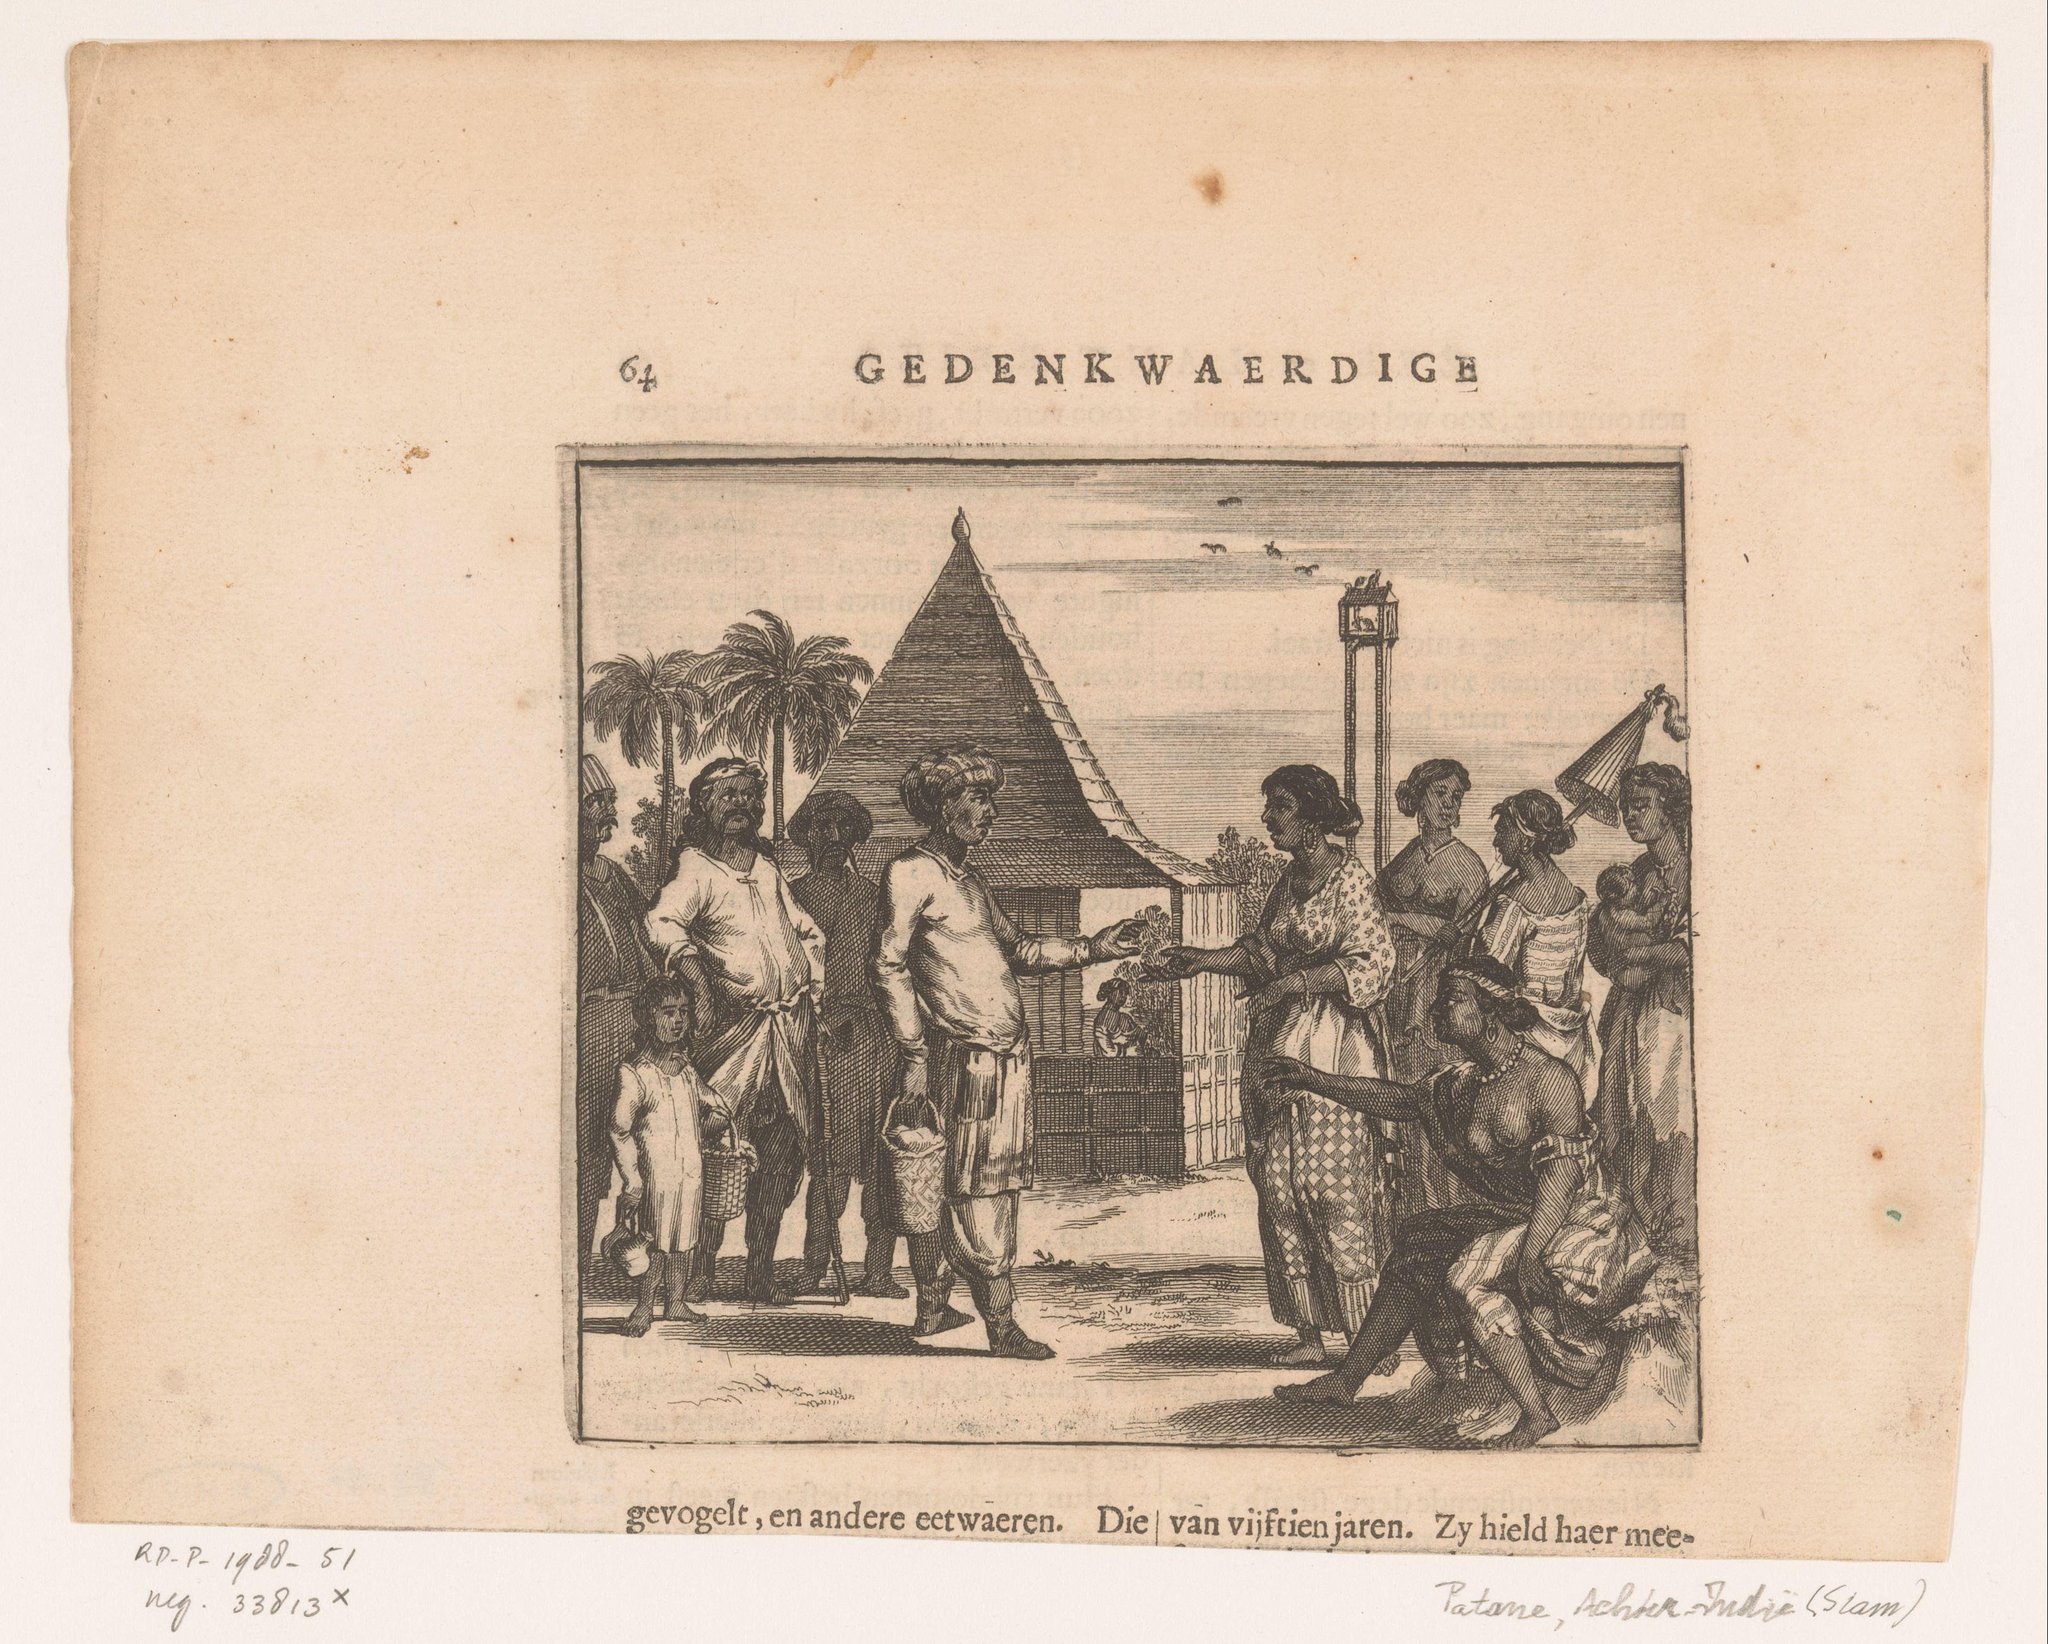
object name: print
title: Ontmoeting tussen mannen en vrouwen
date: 1682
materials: paper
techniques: engraving, letterpress printing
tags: domestic birds kept outside the house, meeting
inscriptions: collector's mark: Lugt 2760, collector's mark: Lugt 2228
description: Prent uit: Nieuhof, Joan. Gedenkwaerdige zee en lantreize door de voornameste landschappen van West en Oostindien (...). 2 dln. Amsterdam: Jacob van Meurs, 1682, dl. 2, p. 64.